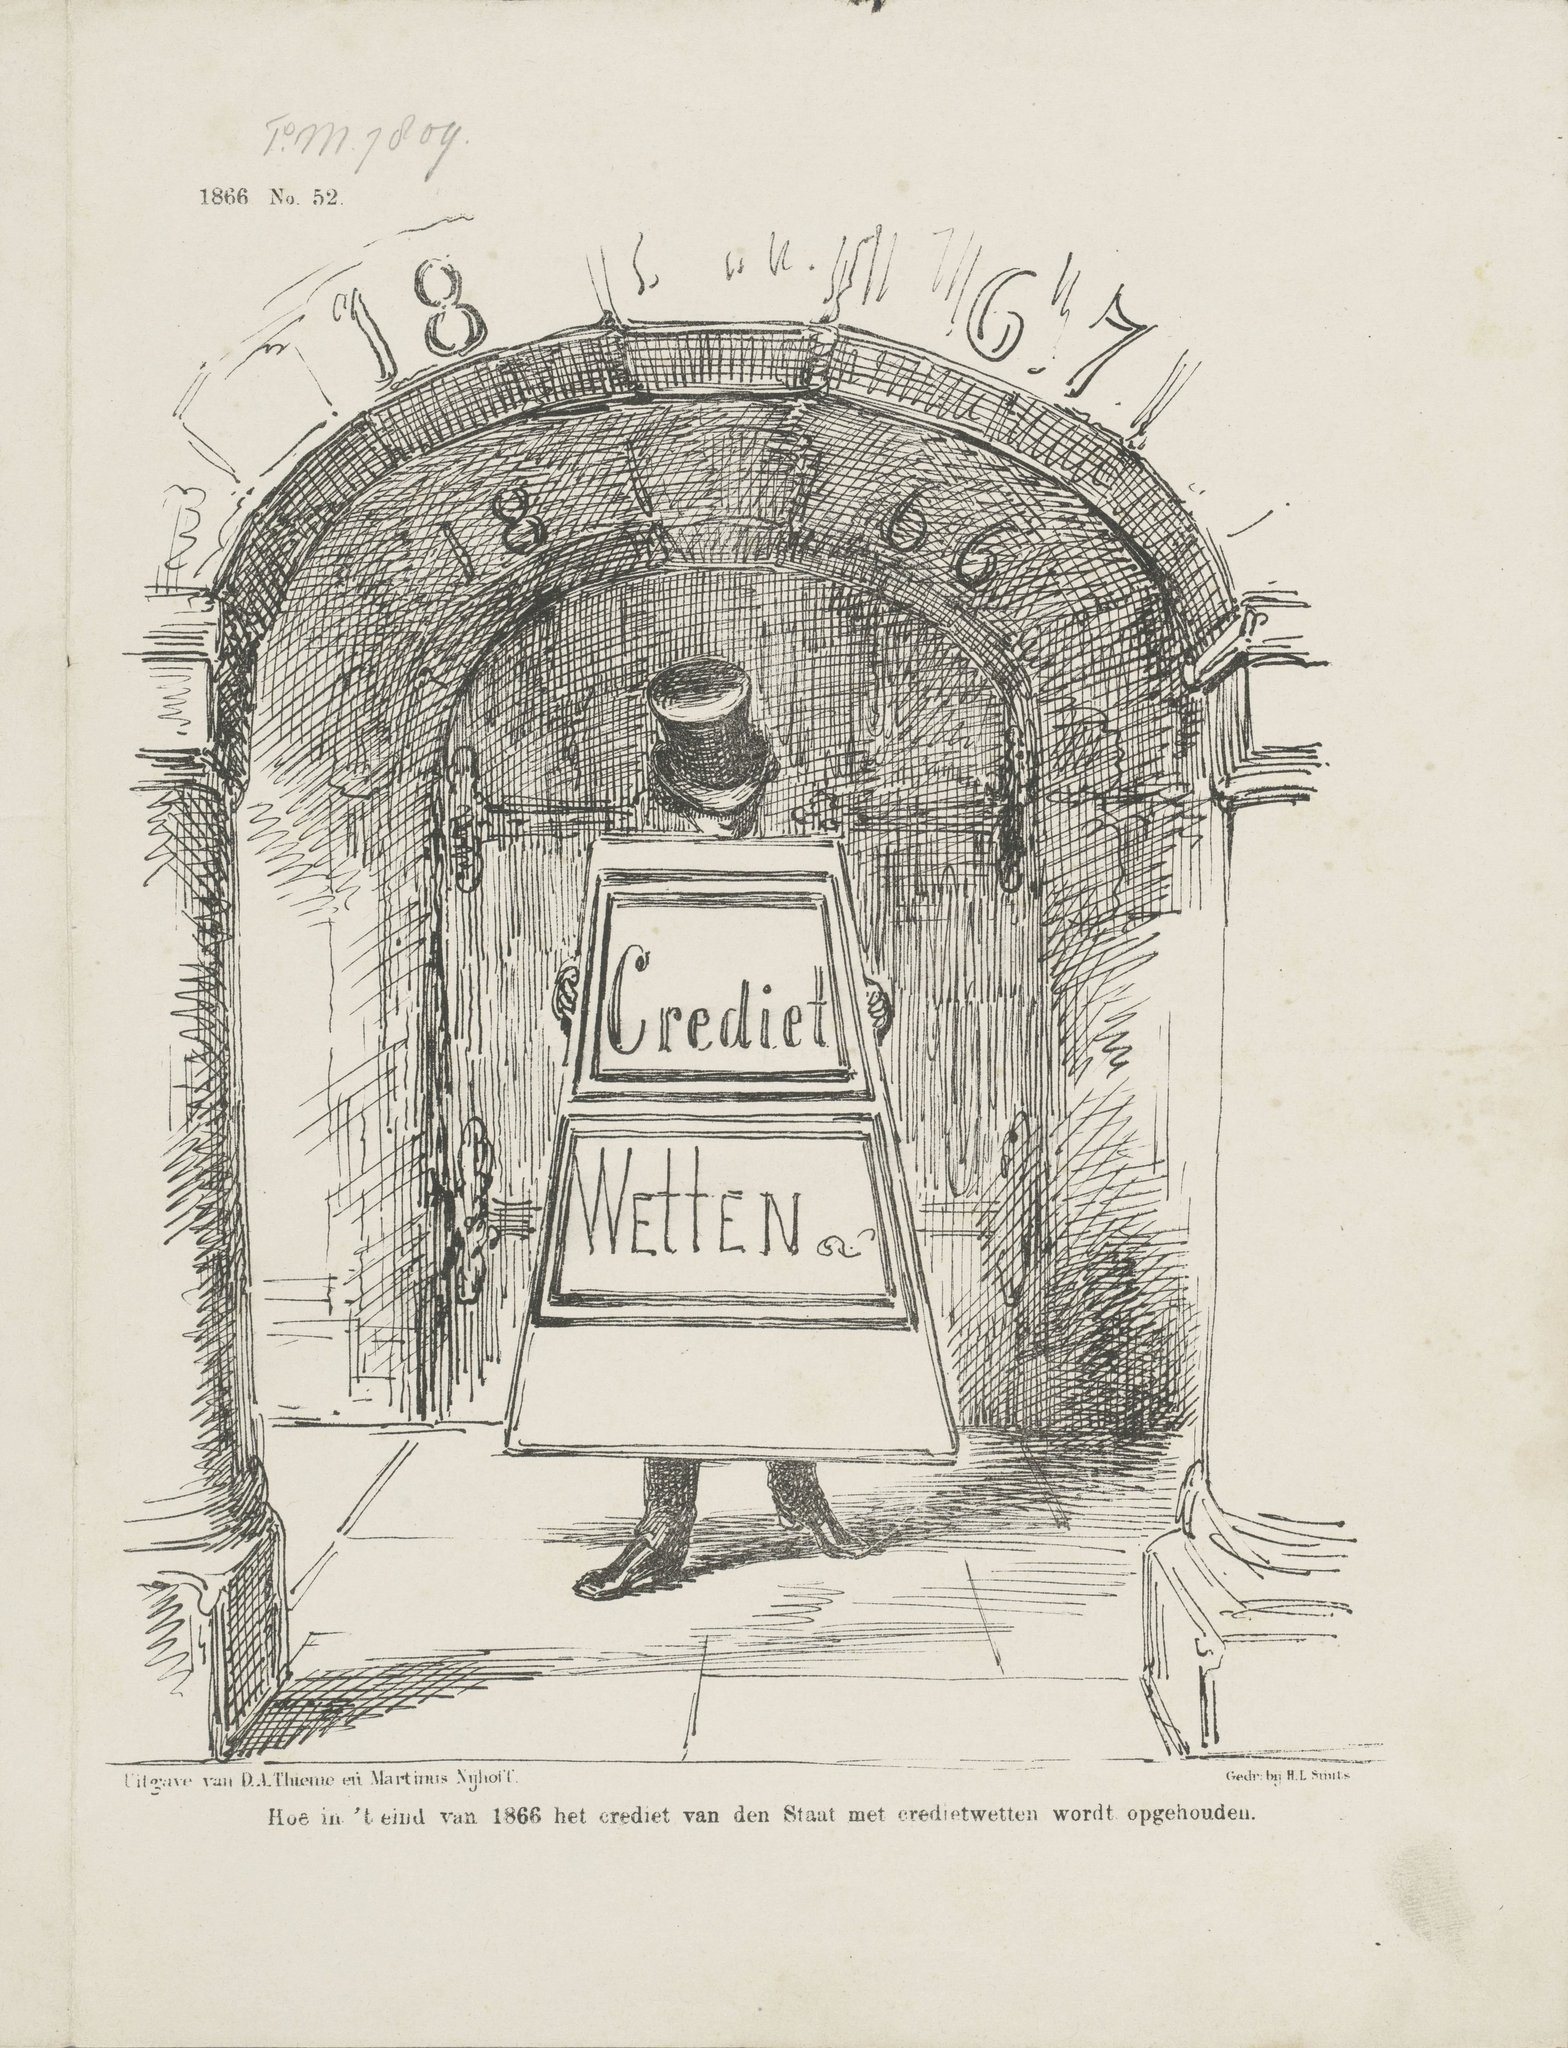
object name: print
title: Spotprent op de late kredietwetten, 1866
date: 1866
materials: paper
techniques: lithograph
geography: the hague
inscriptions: collector's mark: Lugt 2228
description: Spotprent op de pas aan het einde van december door de Minister van Financiën ingediende kredietwetten. Man staande voor een gesloten deur 1866 / 1867. Plaat verschenen bij het weekblad De Nederlandsche Spectator, nr. 52, 29 december 1866.